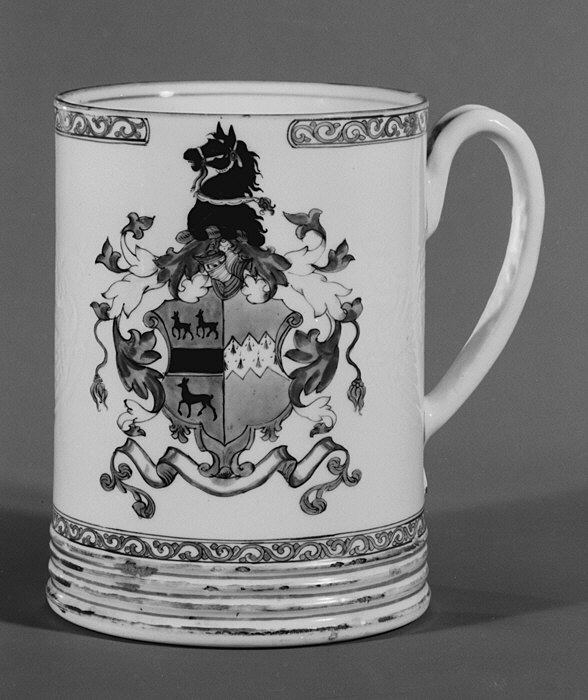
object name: mug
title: Mug (one of a pair)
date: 1720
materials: hard paste porcelain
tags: horses,coat of arms